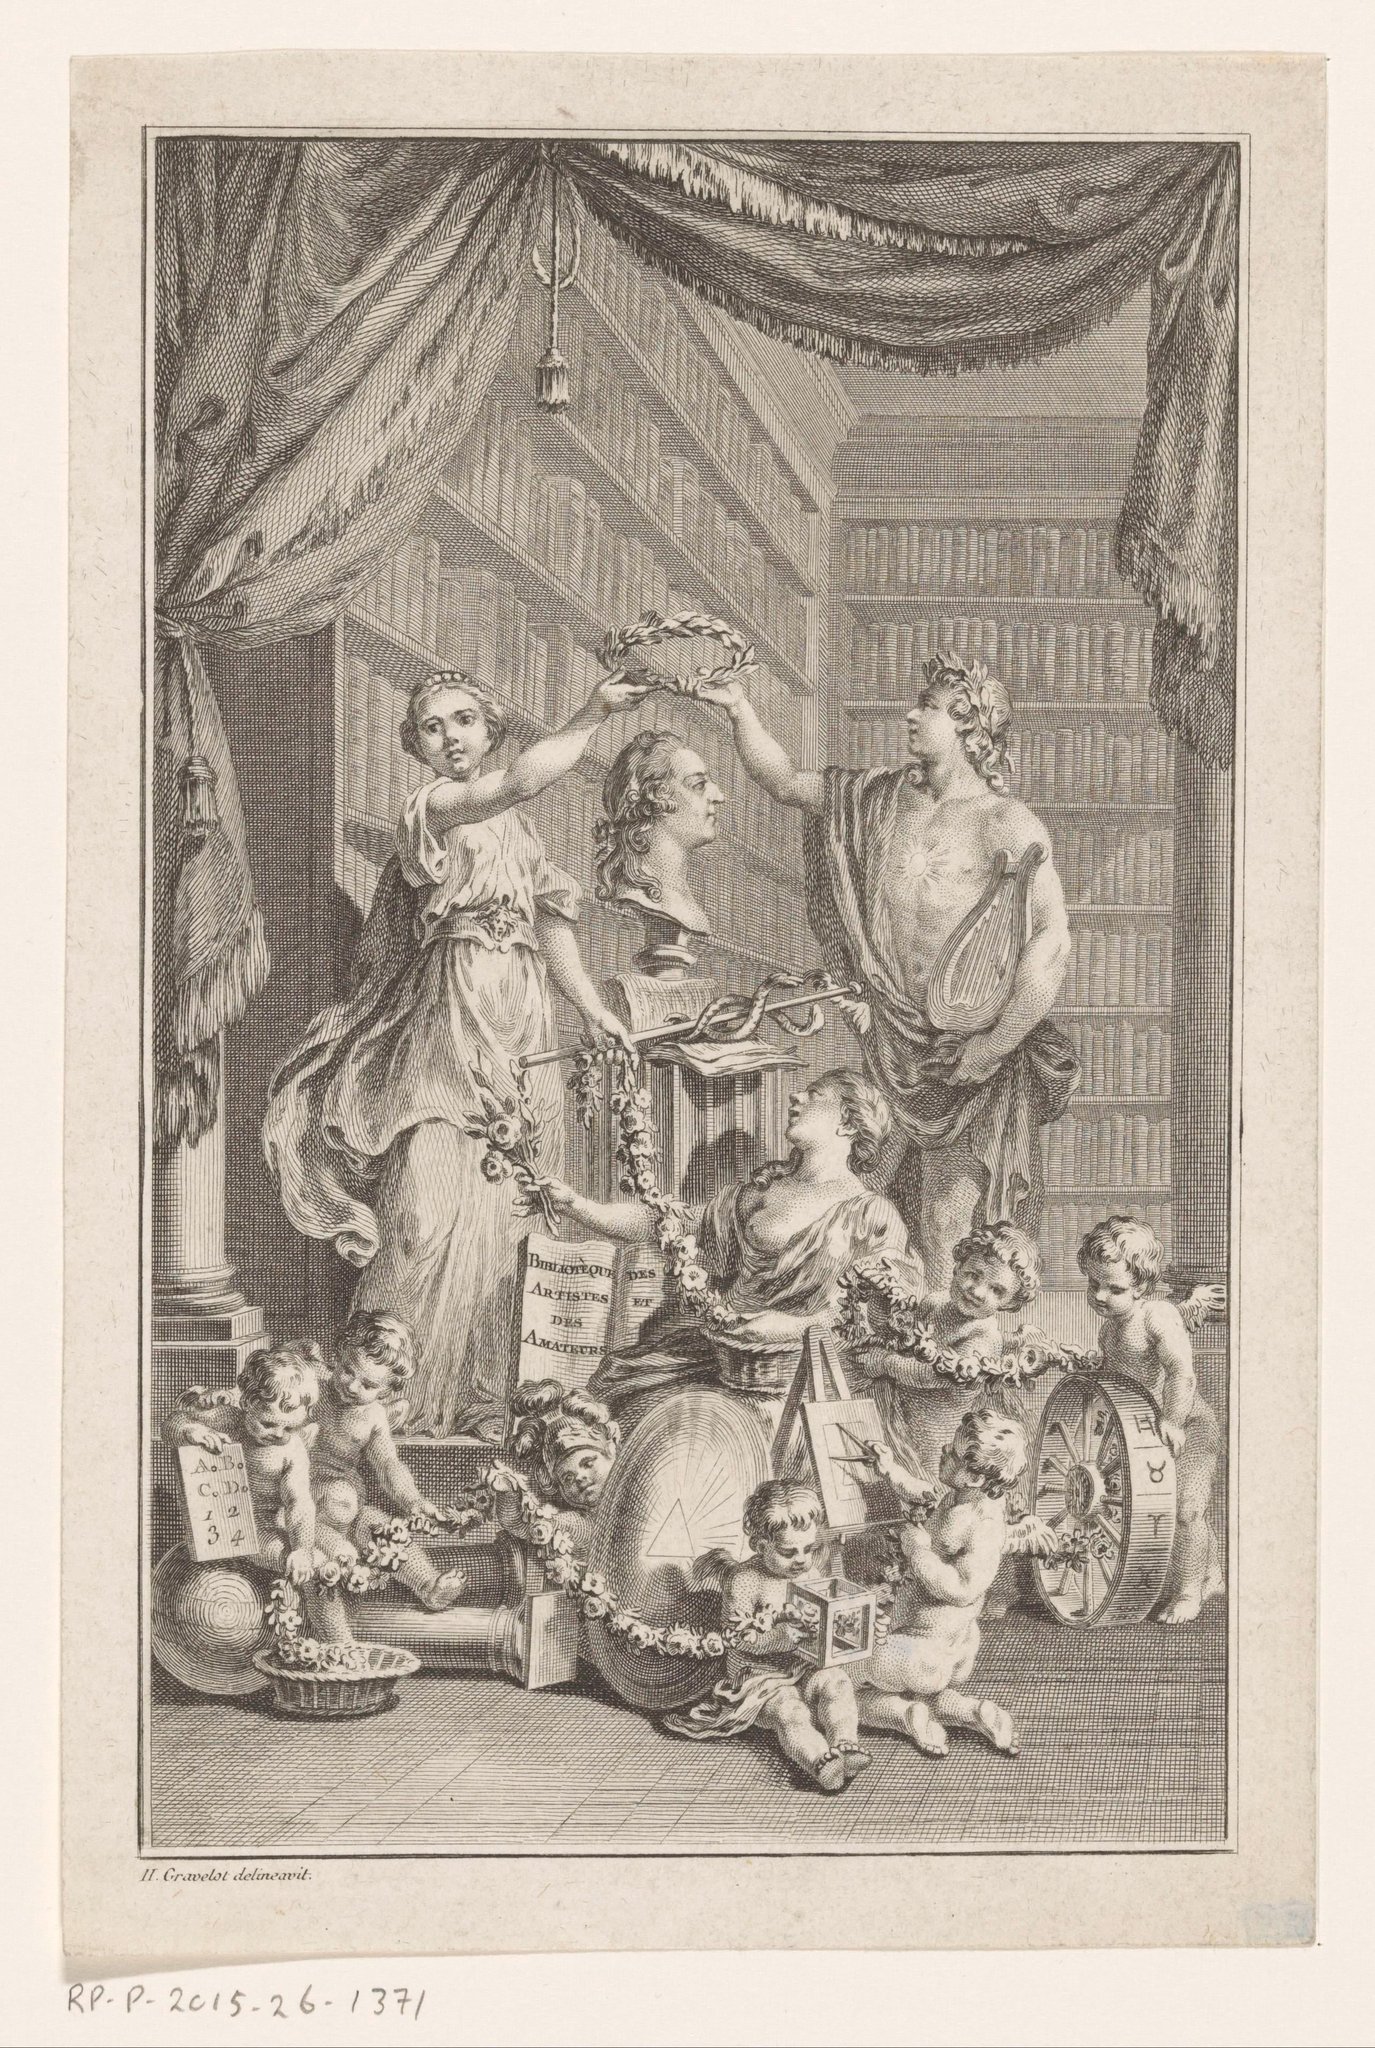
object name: titelblad, titelpagina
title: Titelpagina voor: Jean-Raymond de Petity, Bibliothèque des artistes et des amateurs, 1766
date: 1766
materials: paper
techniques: engraving, etching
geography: paris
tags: louis xv of france, education, science and learning, bookshelves, abstract ideas and concepts (+ abstract concept represented by female figure), cupids: 'amores', 'amoretti', 'putti', specific aspects, allegorical aspects of apollo; apollo as patron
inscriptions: collector's mark: Lugt 2228, collector's mark: Lugt 4780, collector's mark: Lugt 4779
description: Apollo en de personificatie van de wetenschappen houden een kroon boven de buste van Lodewijk XV van Frankrijk. Op de voorgrond zeven putti met attributen die verwijzen naar de wetenschappen. In de achtergrond staan boekenkasten.